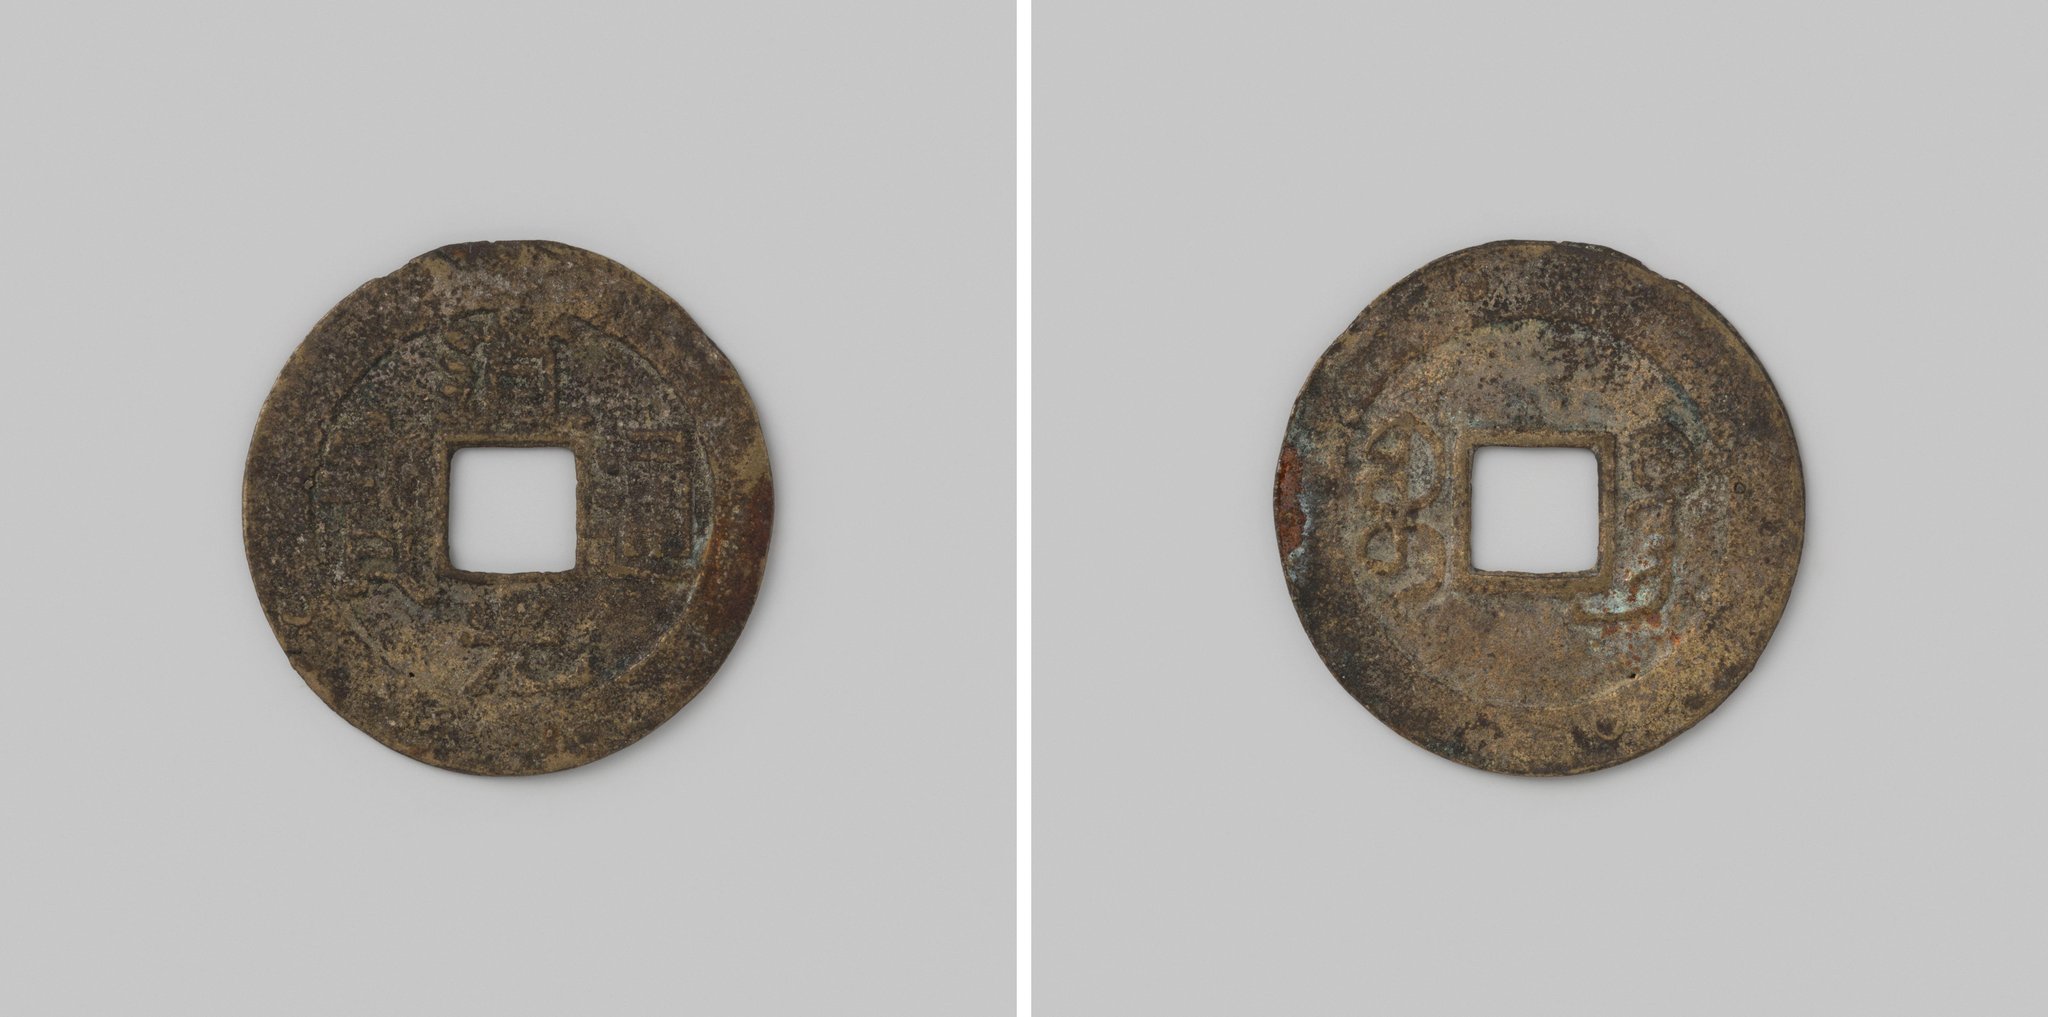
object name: coin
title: Cash van het keizerrijk China van keizer Hsuan Tsung onder de regeringsnaam Tao-Kuang,1821 -1850 uit Kuang in Kwangtung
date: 1821-1850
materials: copper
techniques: casting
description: Koperen munt. Voorzijde: binnen brede opstaande rand rondom vierkante uitsparing in het midden vier kruisgewijze geplaatste Chinese tekens, waarvan twee met de betekenis: Tao kuang. Keerzijde: binnen brede opstaande rand ter weerszijden van vierkante uitsparing in het midden twee Chinese tekens, waarbij het rechter teken met de betekenis: Kuang, in de provincie Kwangtung